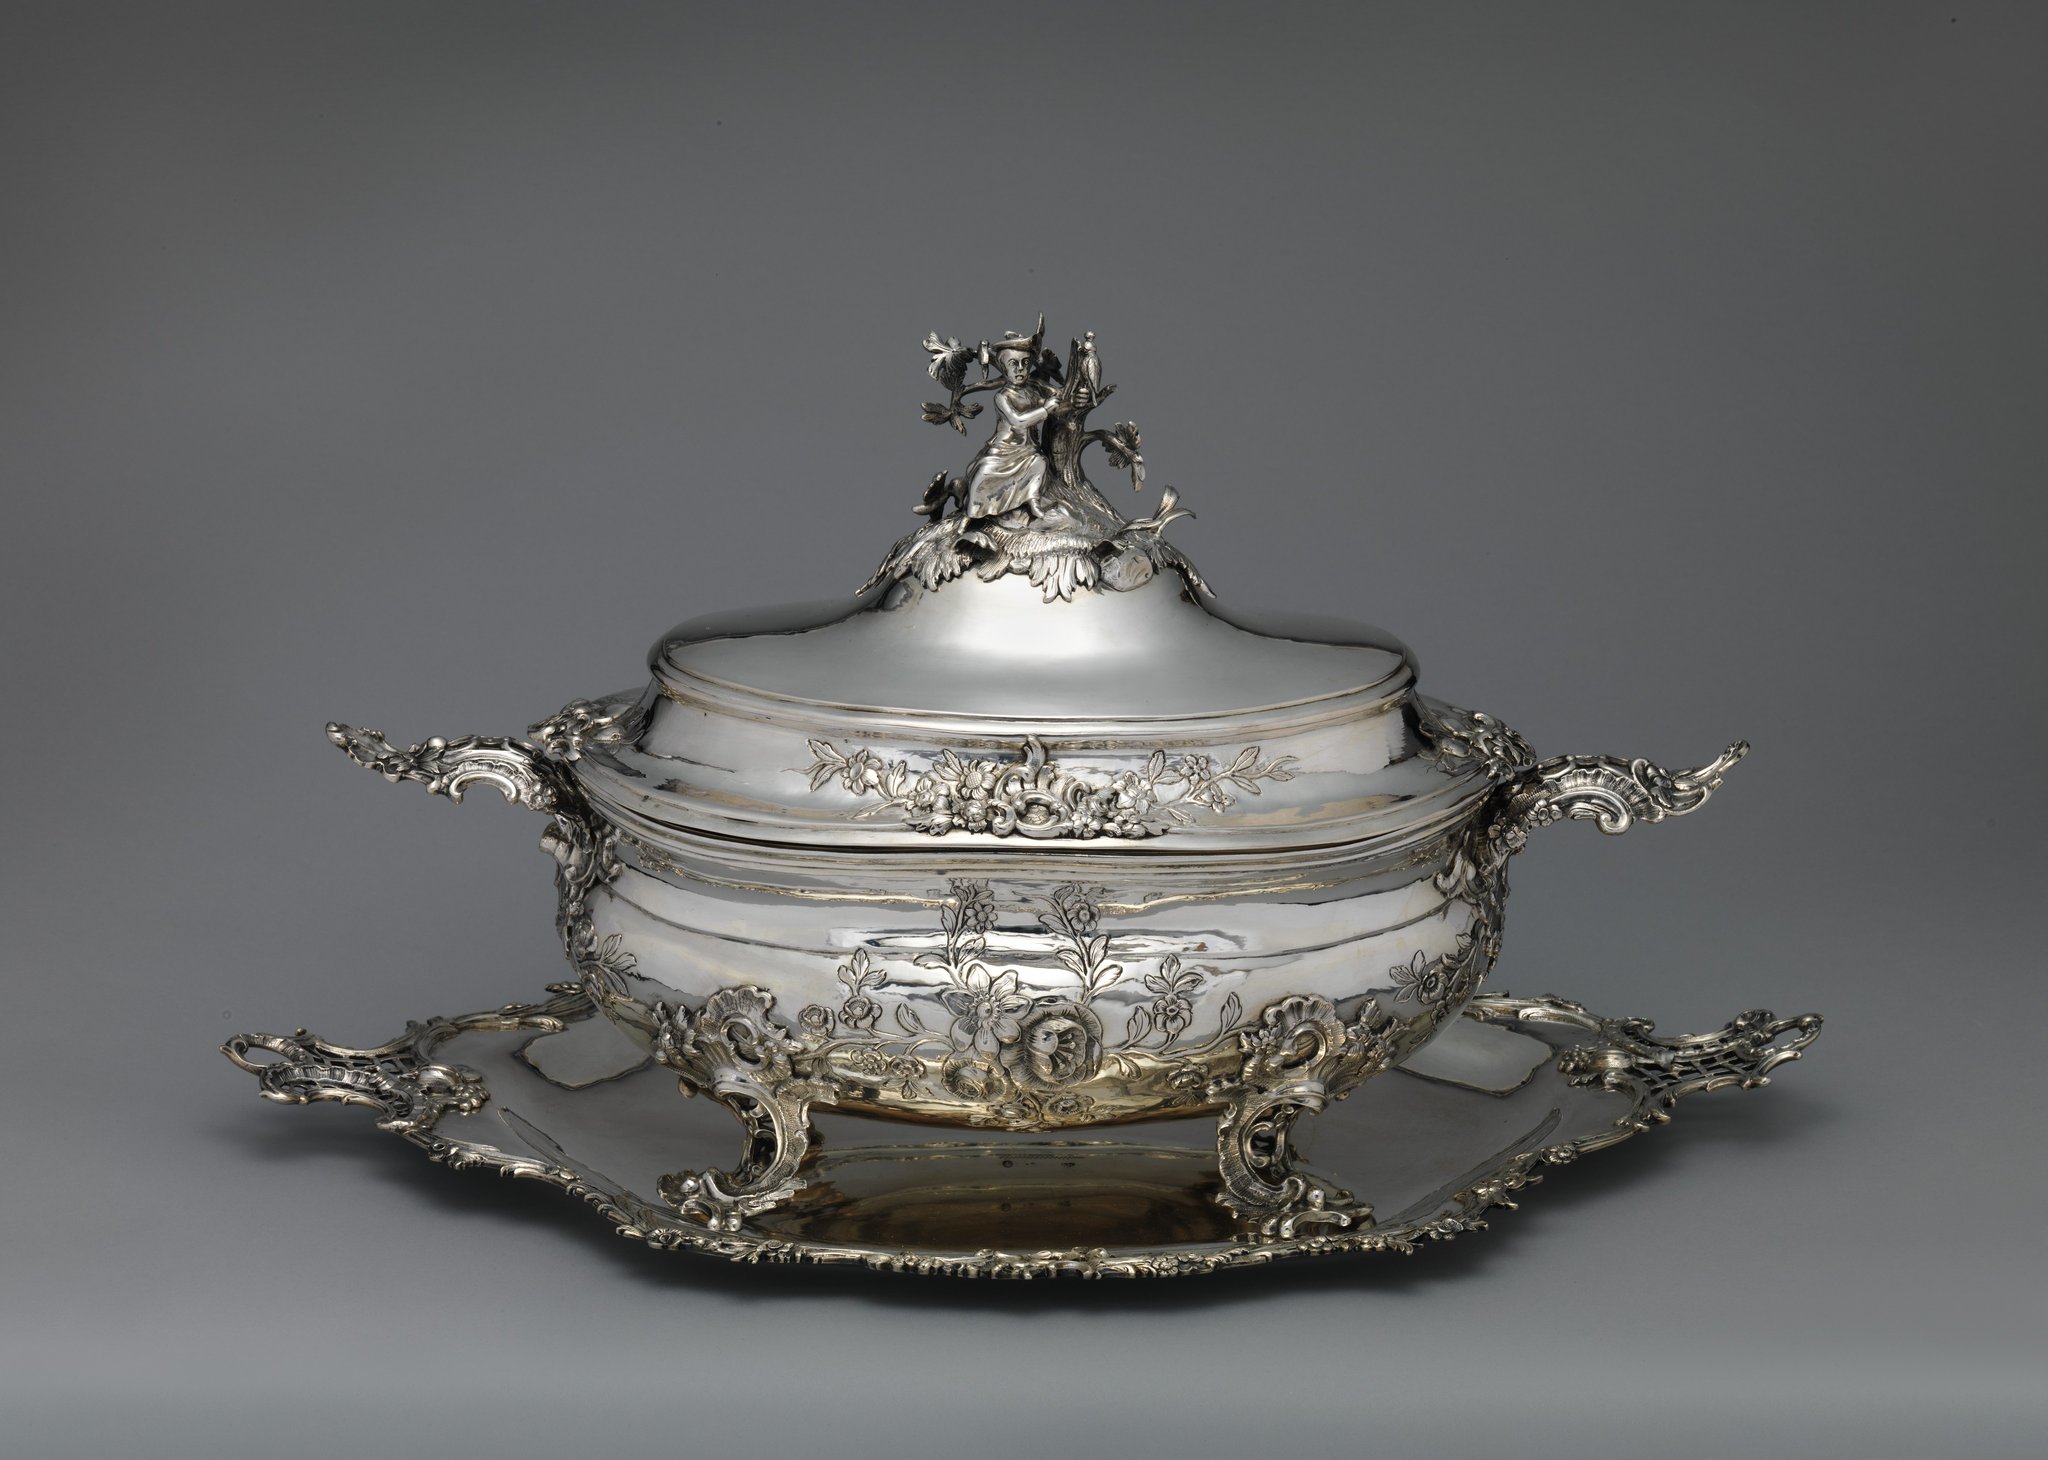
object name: tureen and stand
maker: bernhard heinrich weyhe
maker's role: goldsmith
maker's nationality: german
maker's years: 1702-1782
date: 1769-1771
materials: silver, silver gilt